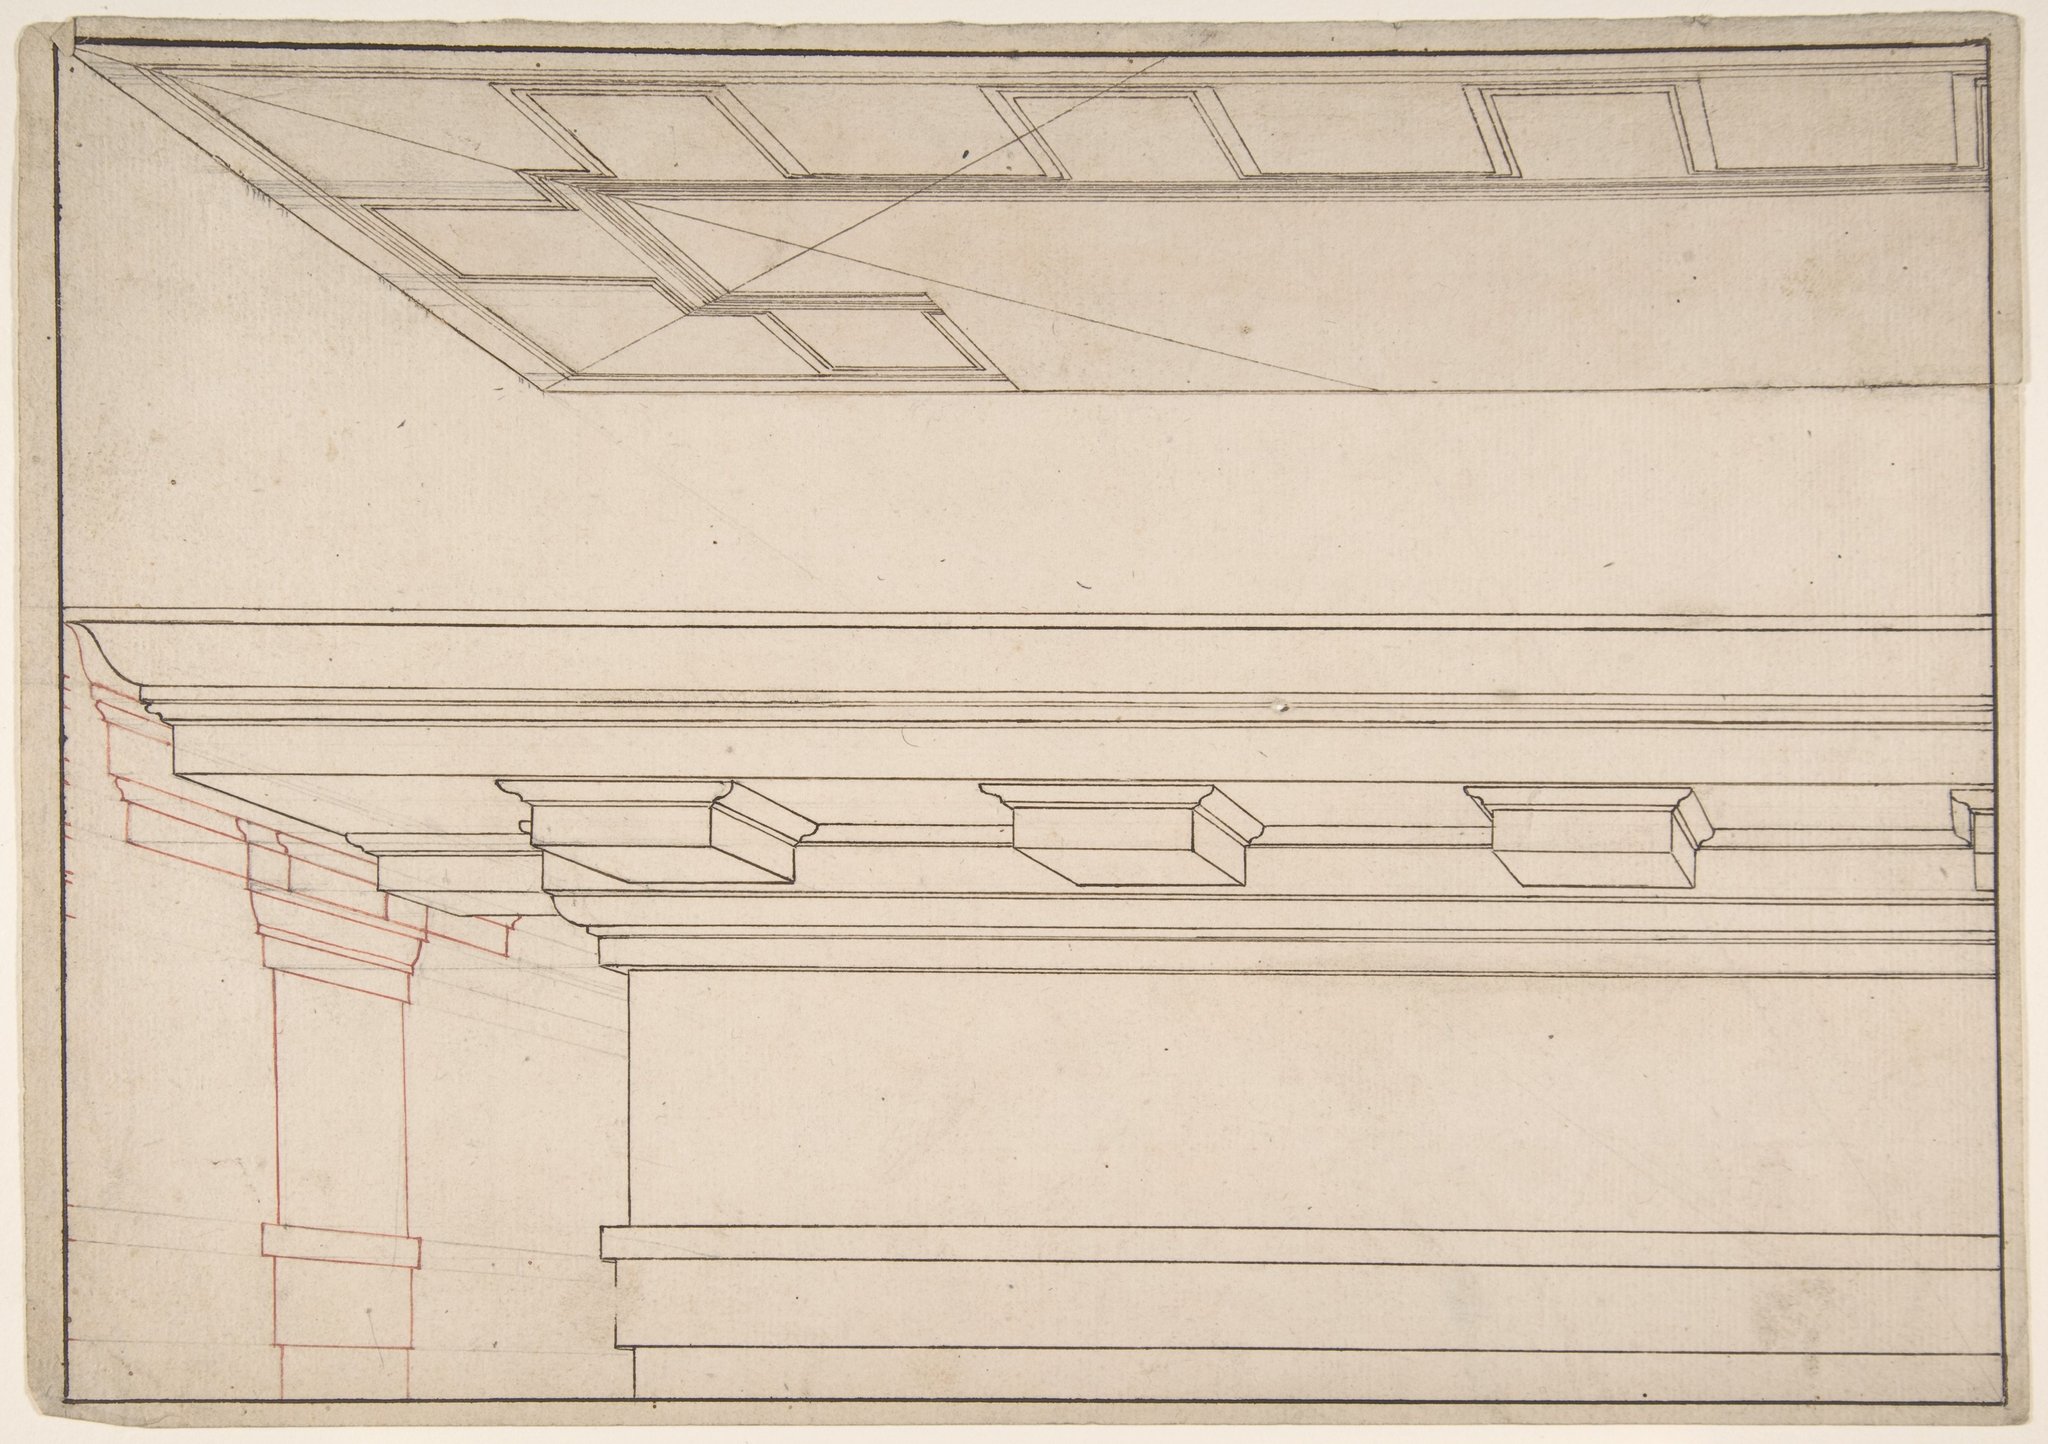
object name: drawing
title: Architectural Study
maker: anonymous, italian, 17th century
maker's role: artist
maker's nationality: italian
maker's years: 1600-1700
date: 1601-1700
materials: graphite, ink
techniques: pen